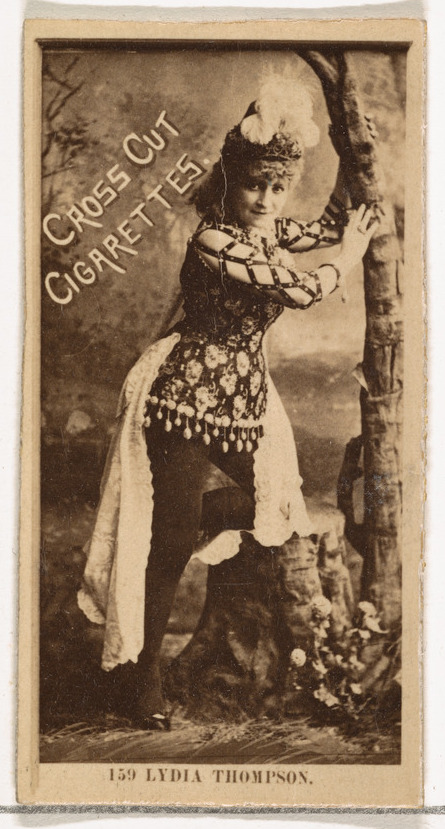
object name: print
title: Card Number 159, Lydia Thompson, from the Actors and Actresses series (N145-2) issued by Duke Sons & Co. to promote Cross Cut Cigarettes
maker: w. duke, sons & co.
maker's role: publisher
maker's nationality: american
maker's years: 1870-1920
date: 1880-1889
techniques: albumen silver print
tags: portraits,women,actresses